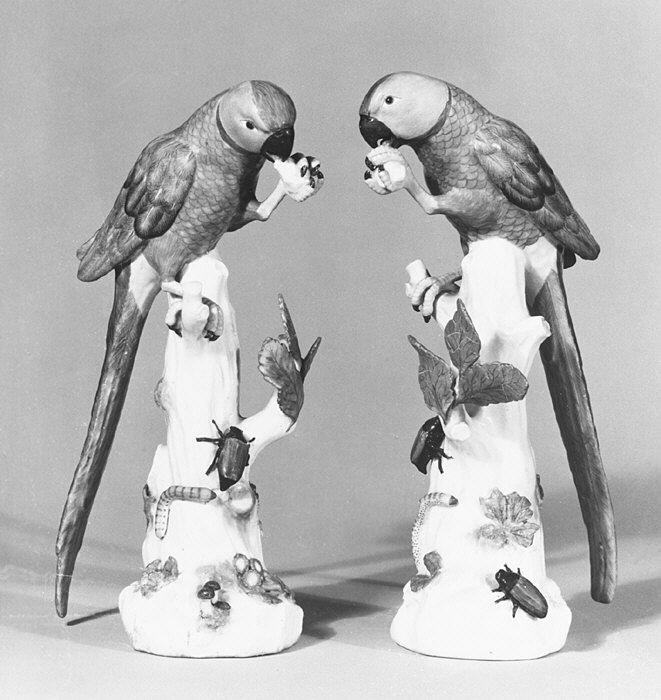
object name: figure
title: Indian parrot (one of a pair)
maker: meissen manufactory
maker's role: manufactory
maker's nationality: german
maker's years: 1710-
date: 1741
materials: hard paste porcelain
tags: parrots,insects,leaves